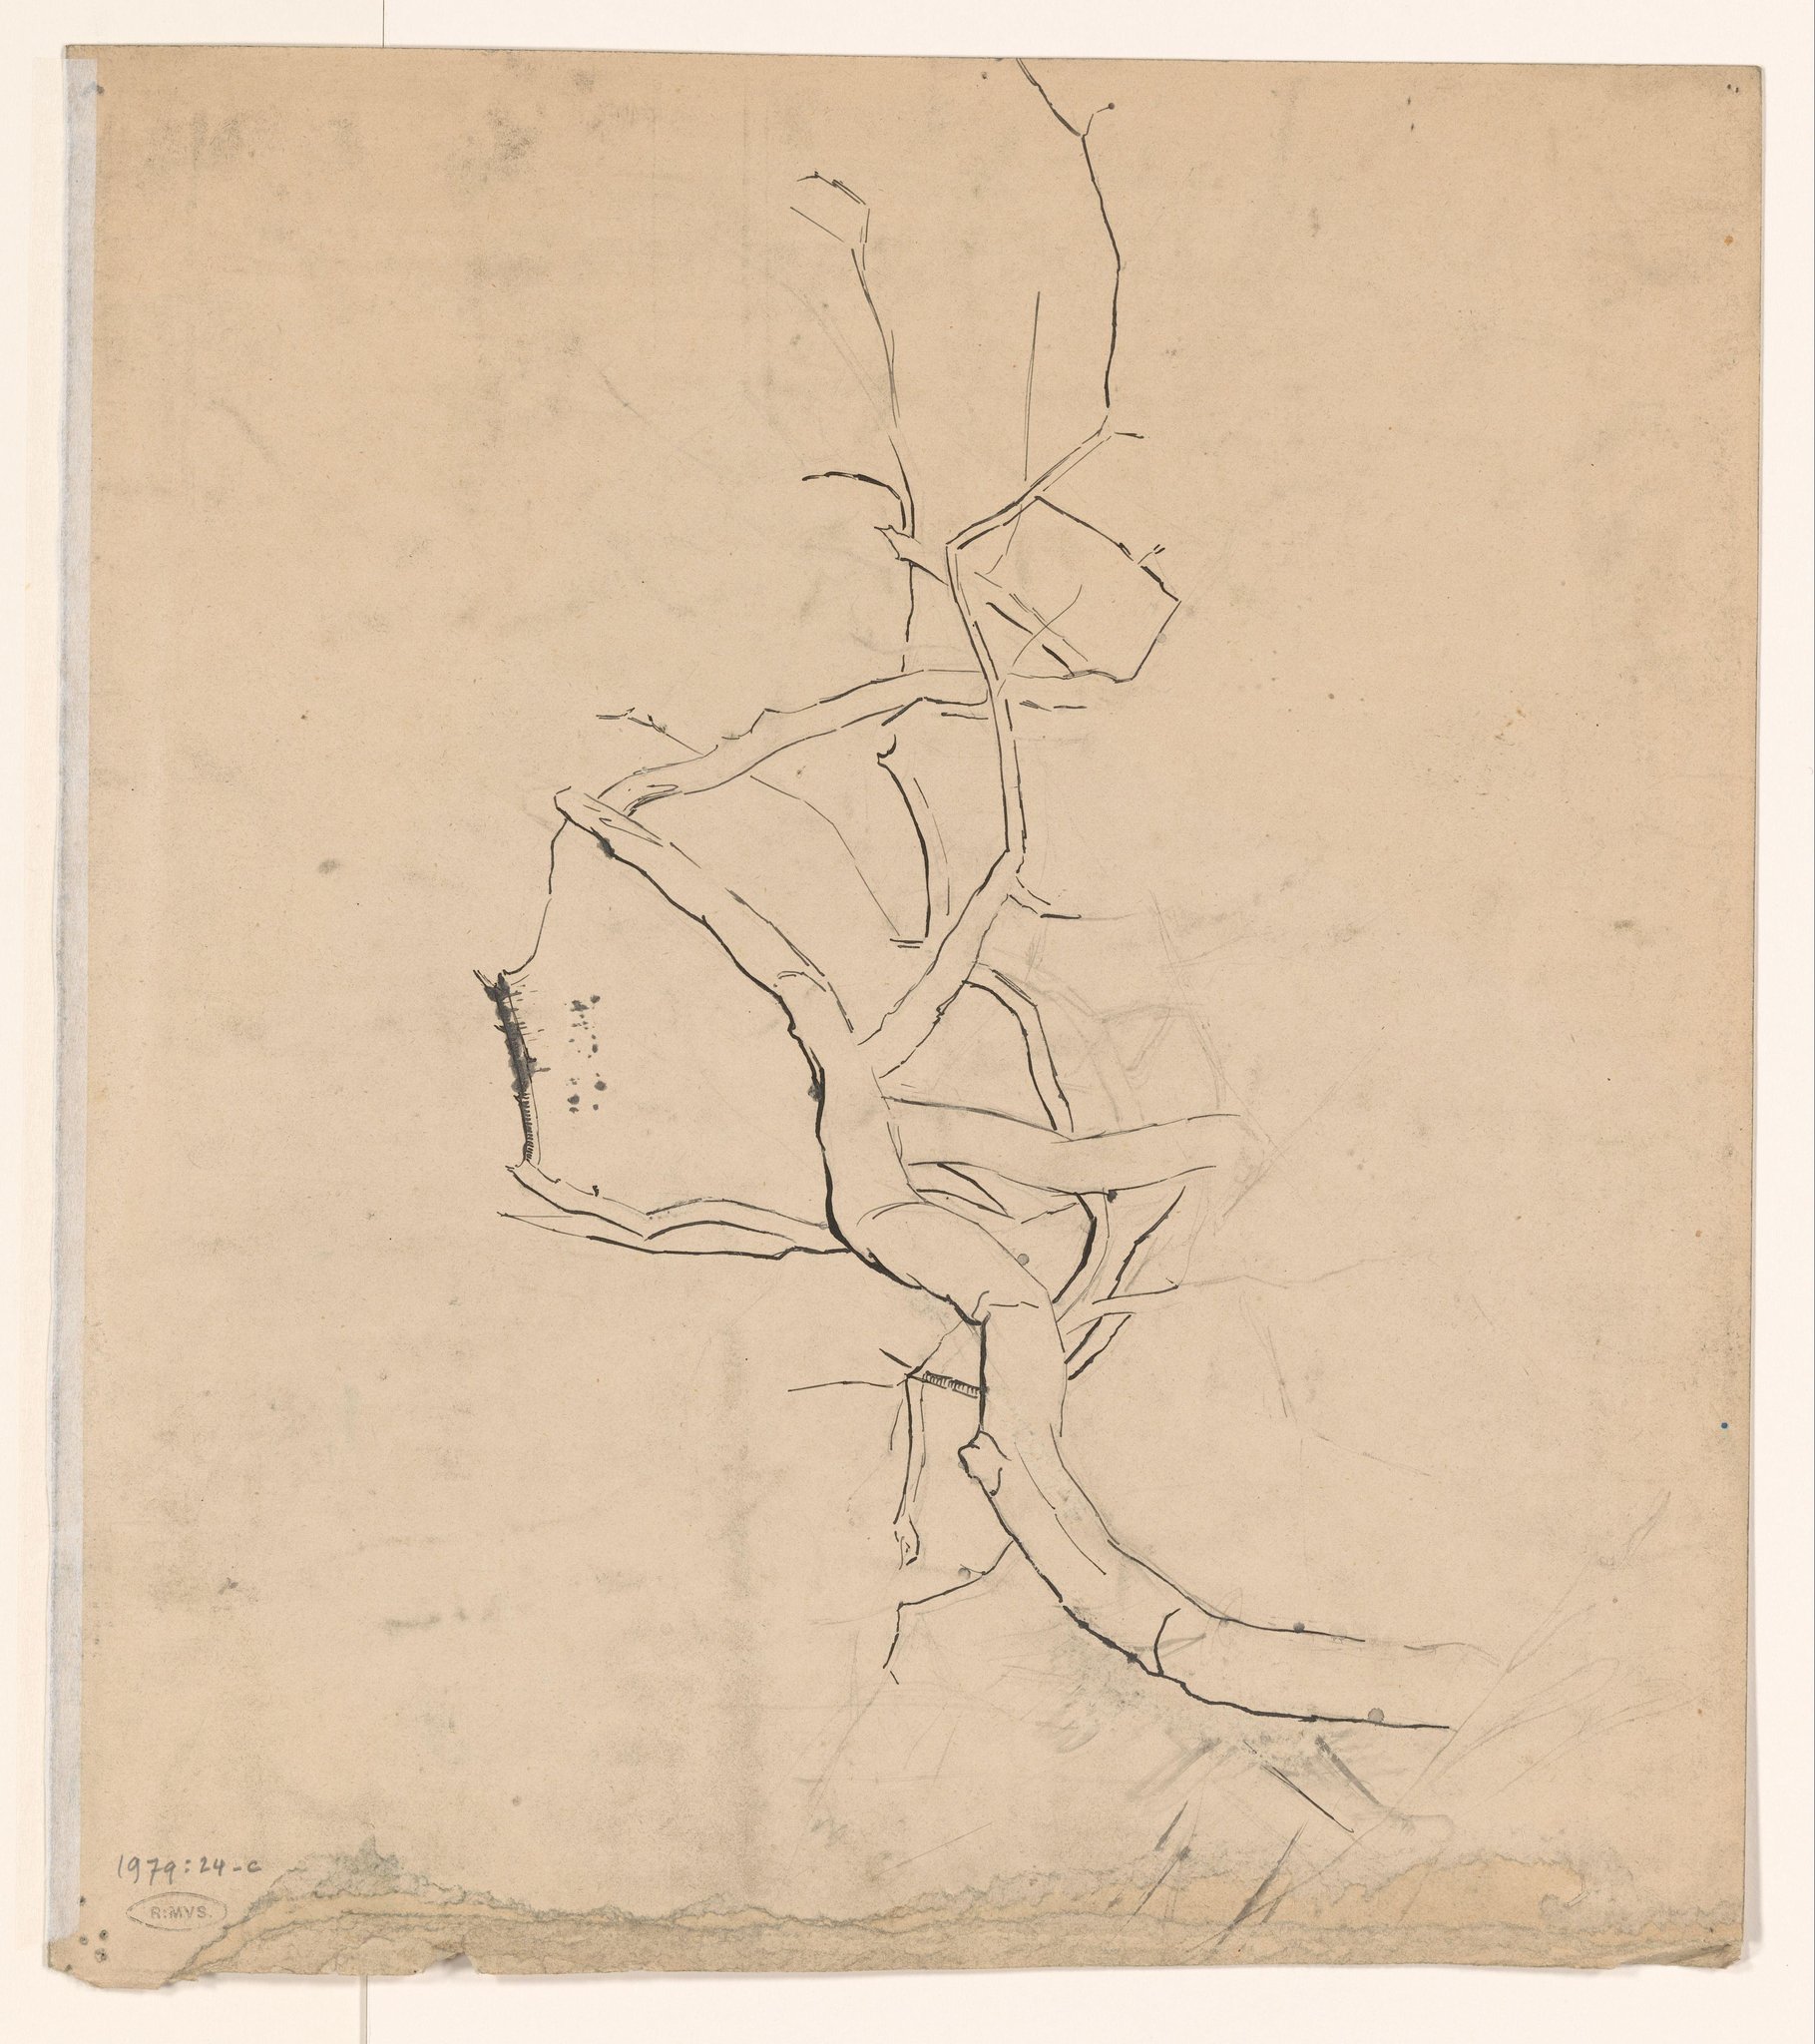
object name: drawing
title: Boomstudie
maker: coba steenhoff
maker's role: draughtsman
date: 1904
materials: ink, paper, pencil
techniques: pen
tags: trees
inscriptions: date